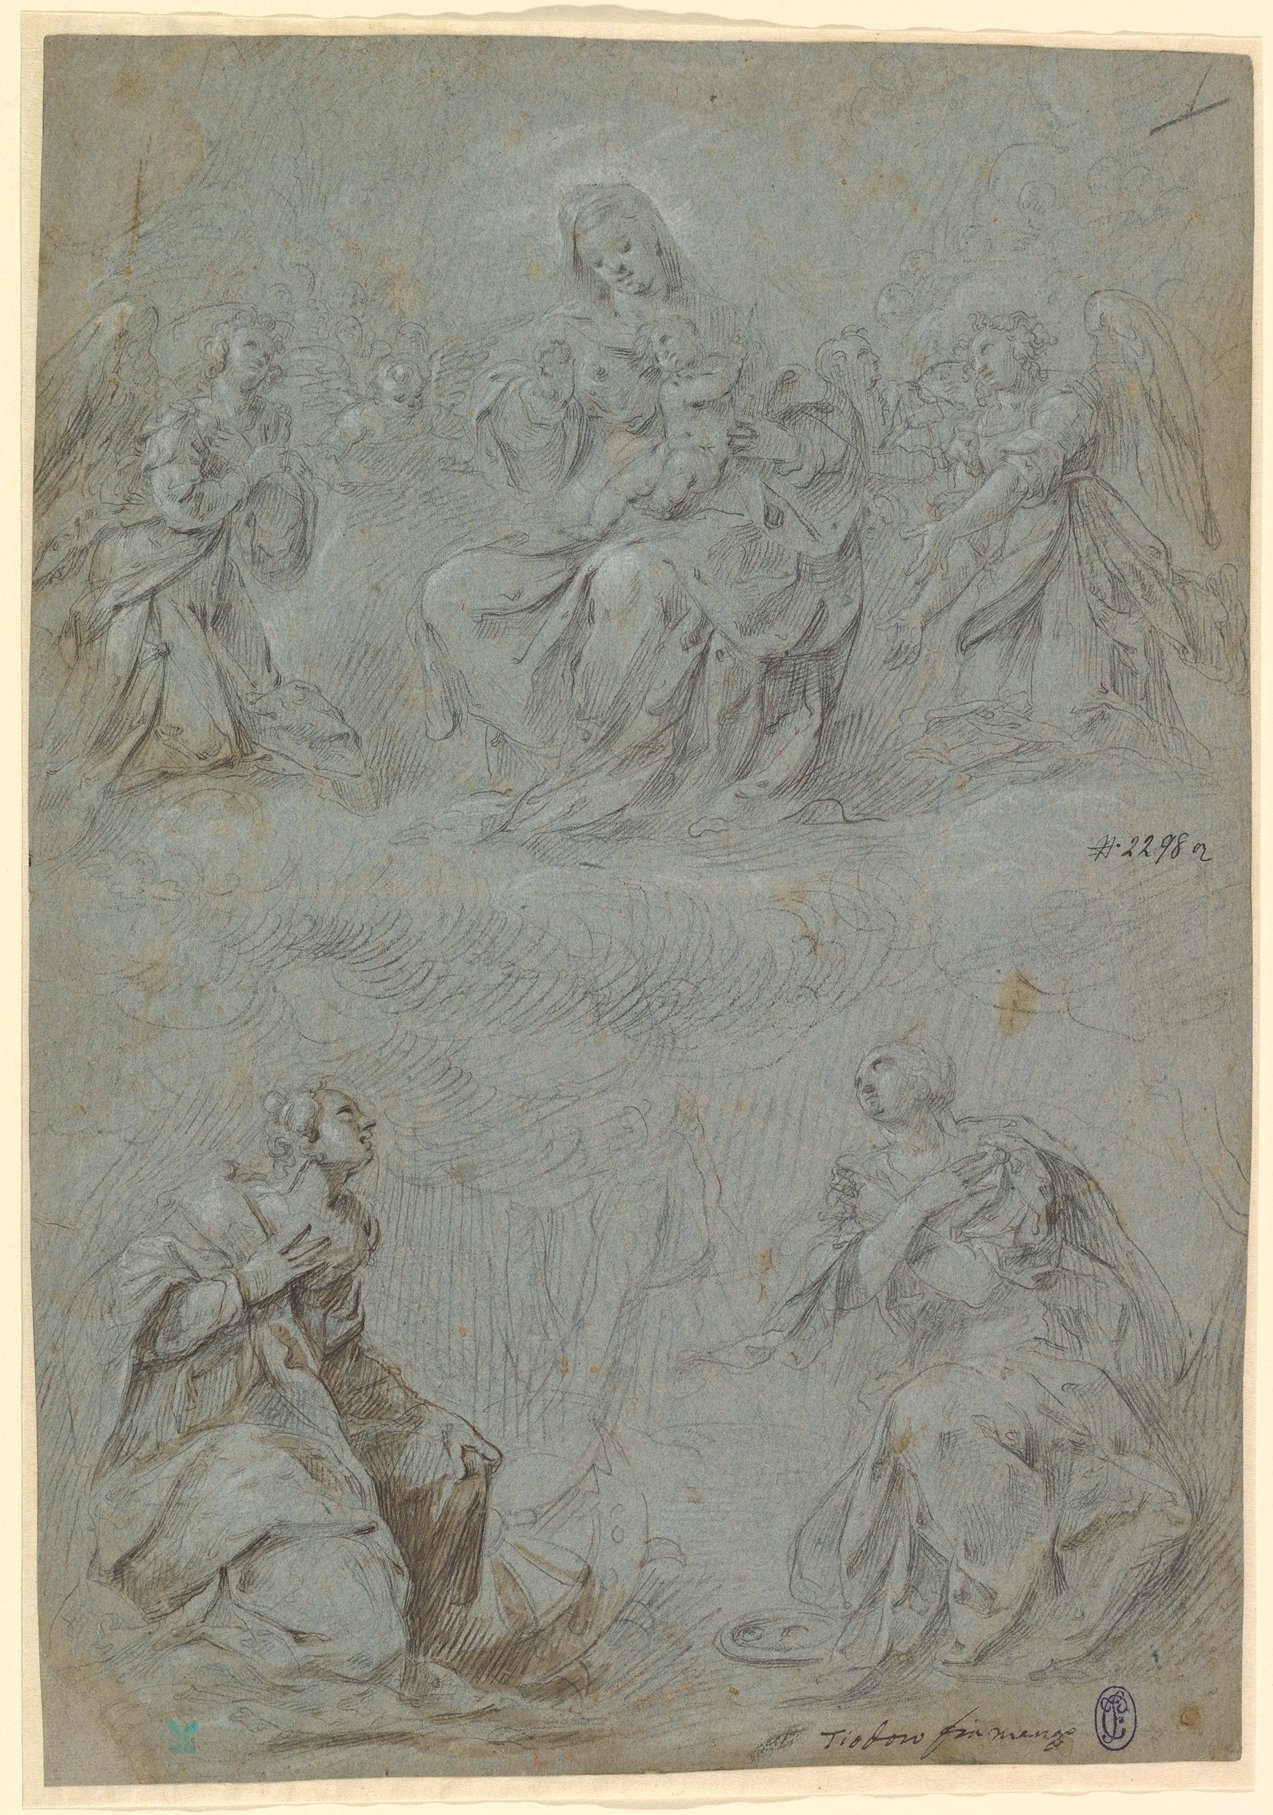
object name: drawing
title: The Virgin and Child in Glory Adored by Saints Catherine and Lucy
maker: dirck hendricksz., called centen, also called teodoro d'errico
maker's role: artist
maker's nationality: netherlandish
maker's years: 1542-1618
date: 1534-1633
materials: chalk, ink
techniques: brush, heightening, pen, wash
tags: angels,madonna and child,saint catherine